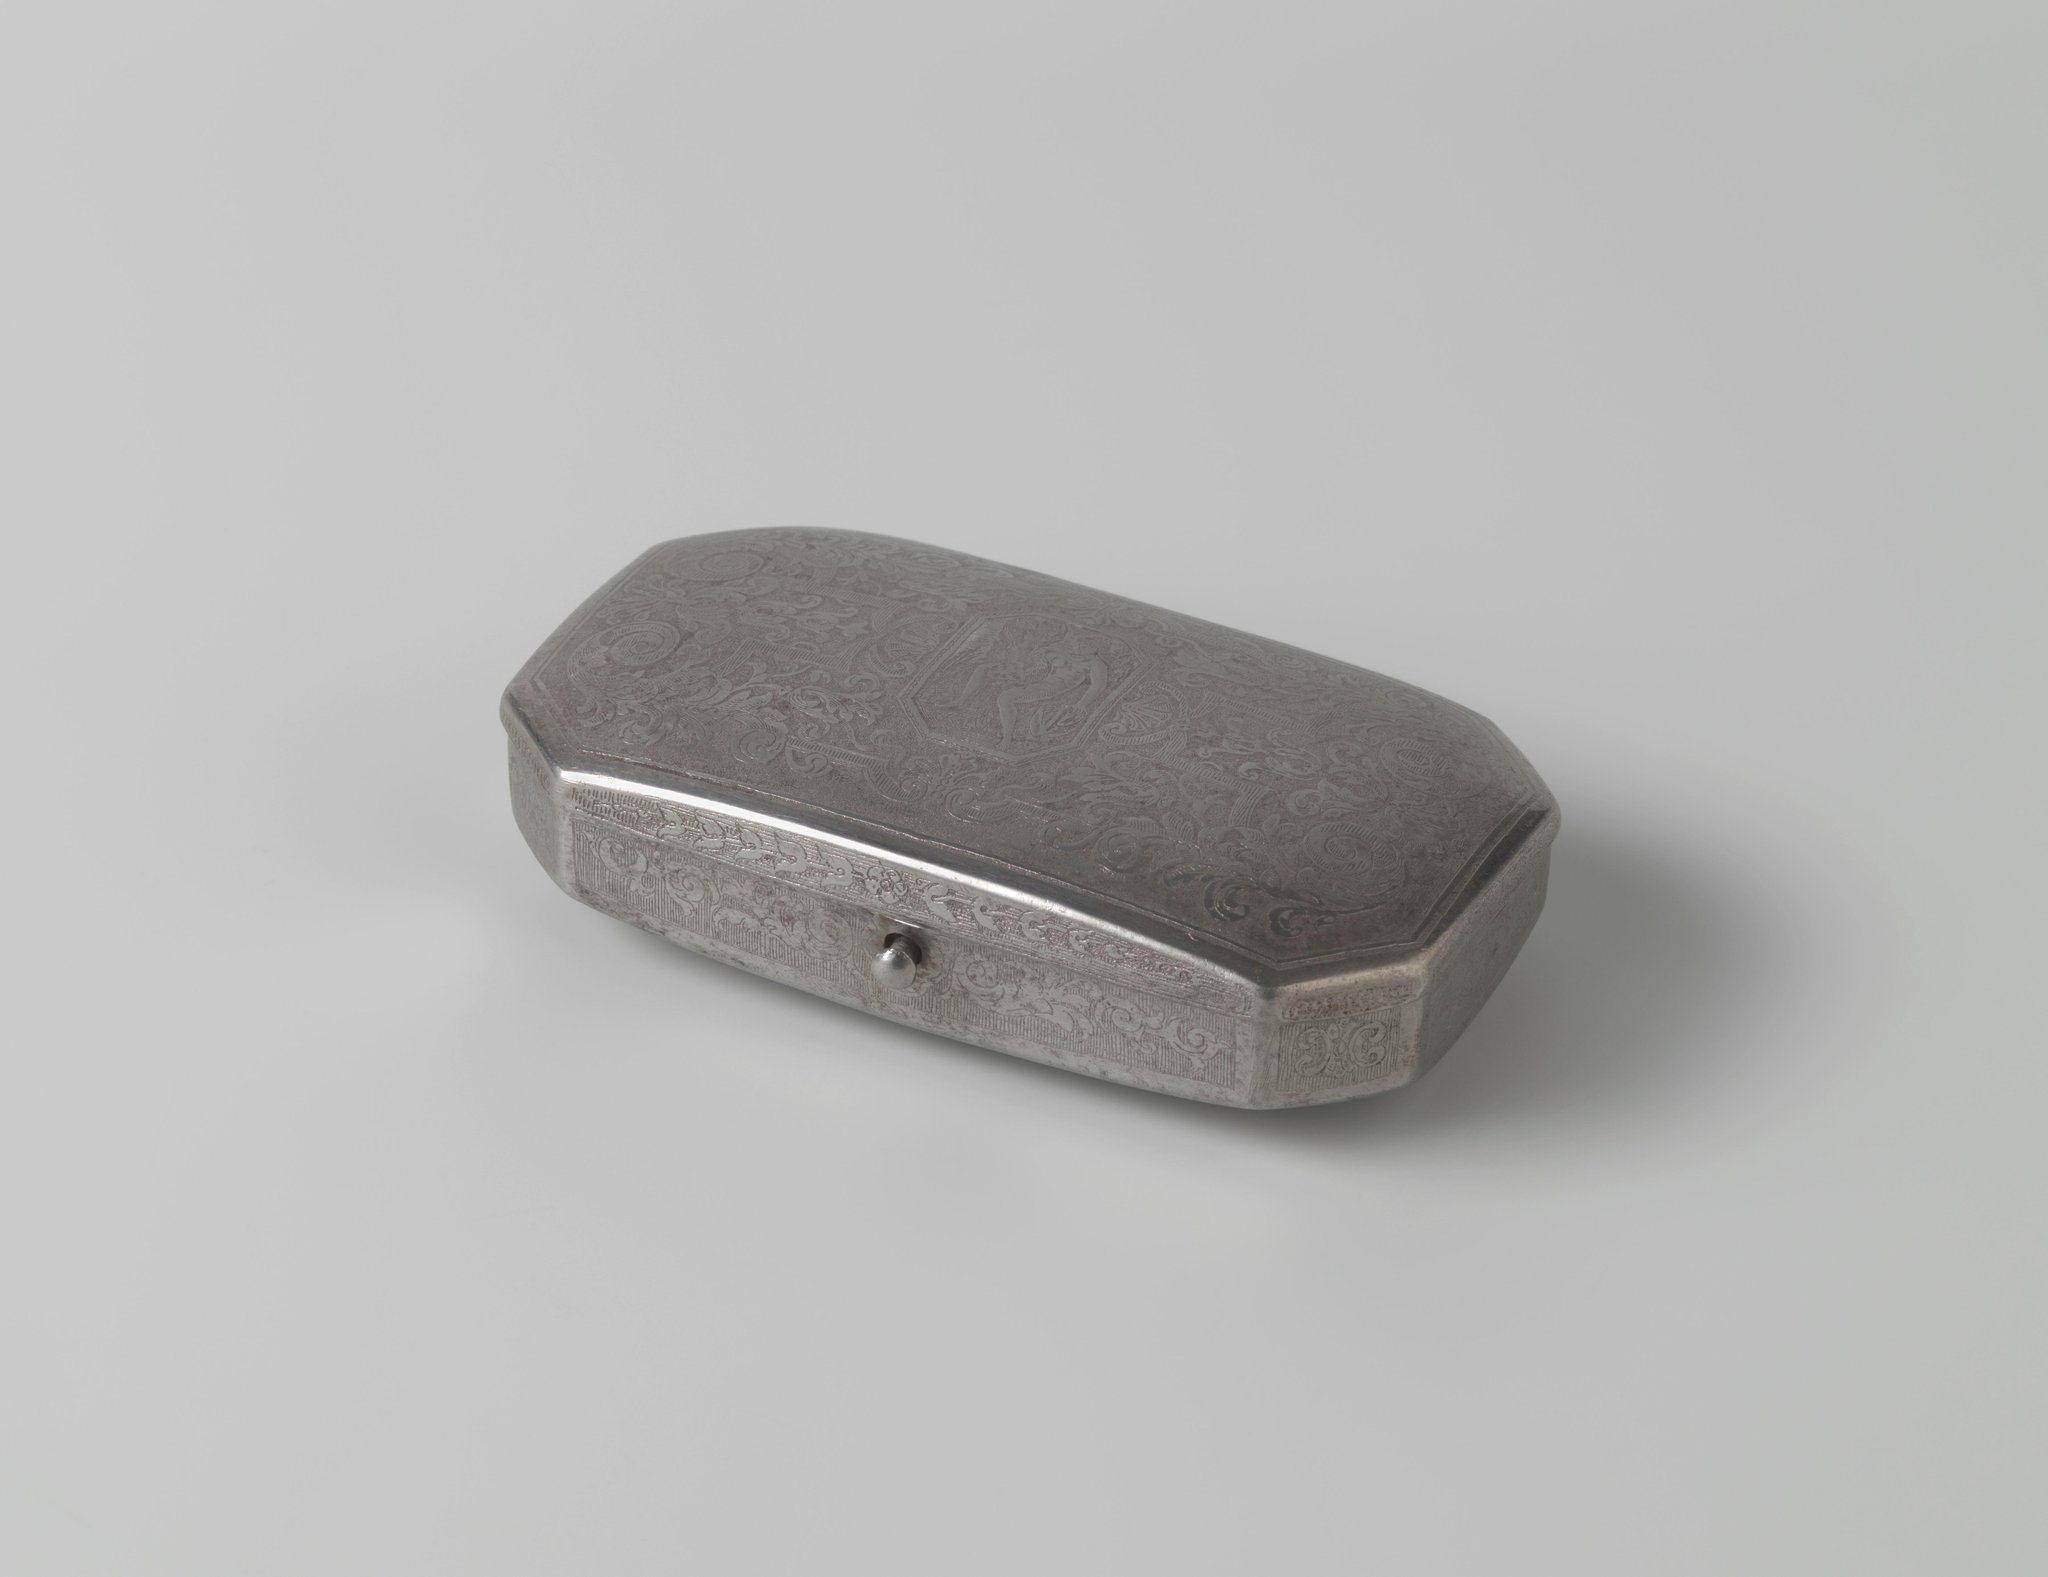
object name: tobacco box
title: Tabaksdoos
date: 1746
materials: iron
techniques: etching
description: Een ovale ijzeren tabaksdoos met afgeschuinde hoeken. Op het deksel etsen, rondom fraaie ornamenten. Op de bodem een vrouwenbuste, eveneens tussen ornamenten. Dergelijke ook op de kanten.